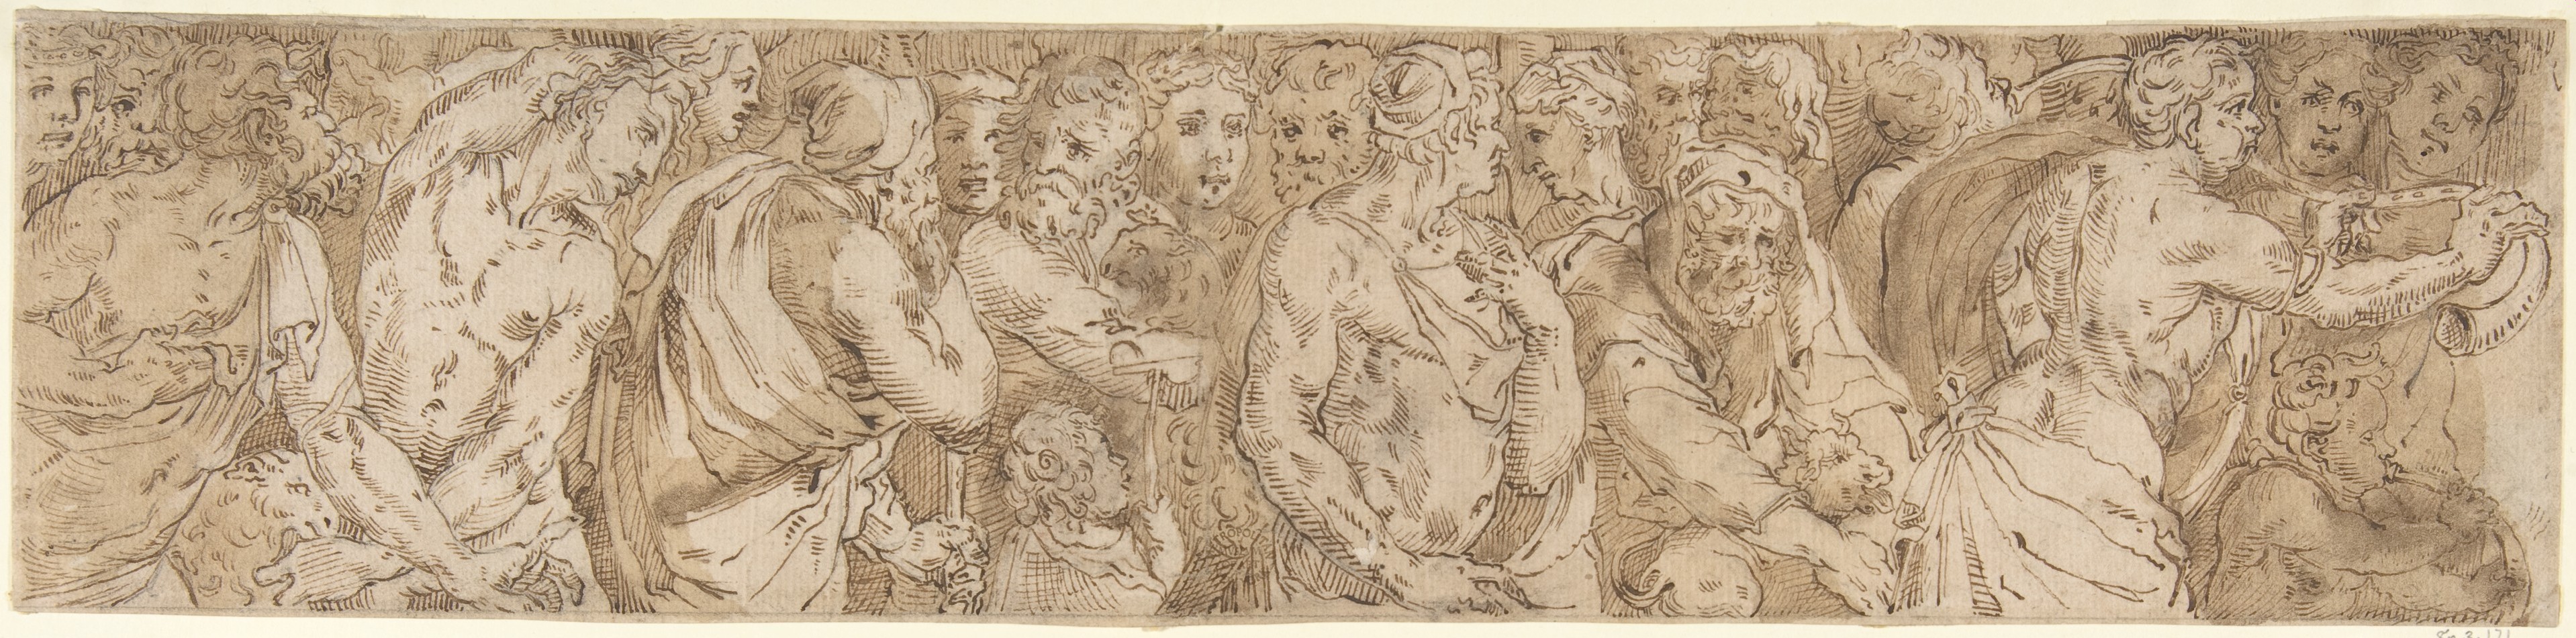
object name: drawing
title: Procession (left-hand portion of border below Sacrifice of Isaac, inlaid-marble pavement, Siena Cathedral)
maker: domenico beccafumi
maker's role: artist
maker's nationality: italian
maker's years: 1484-1551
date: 1520-1550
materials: chalk, ink, drawing material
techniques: brush, pen, wash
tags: men